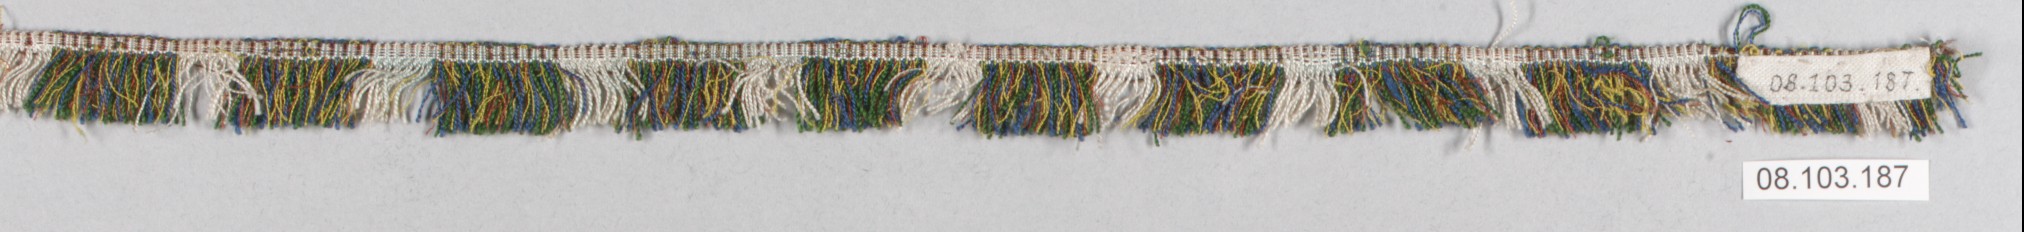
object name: fringe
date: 1801-1900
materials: silk